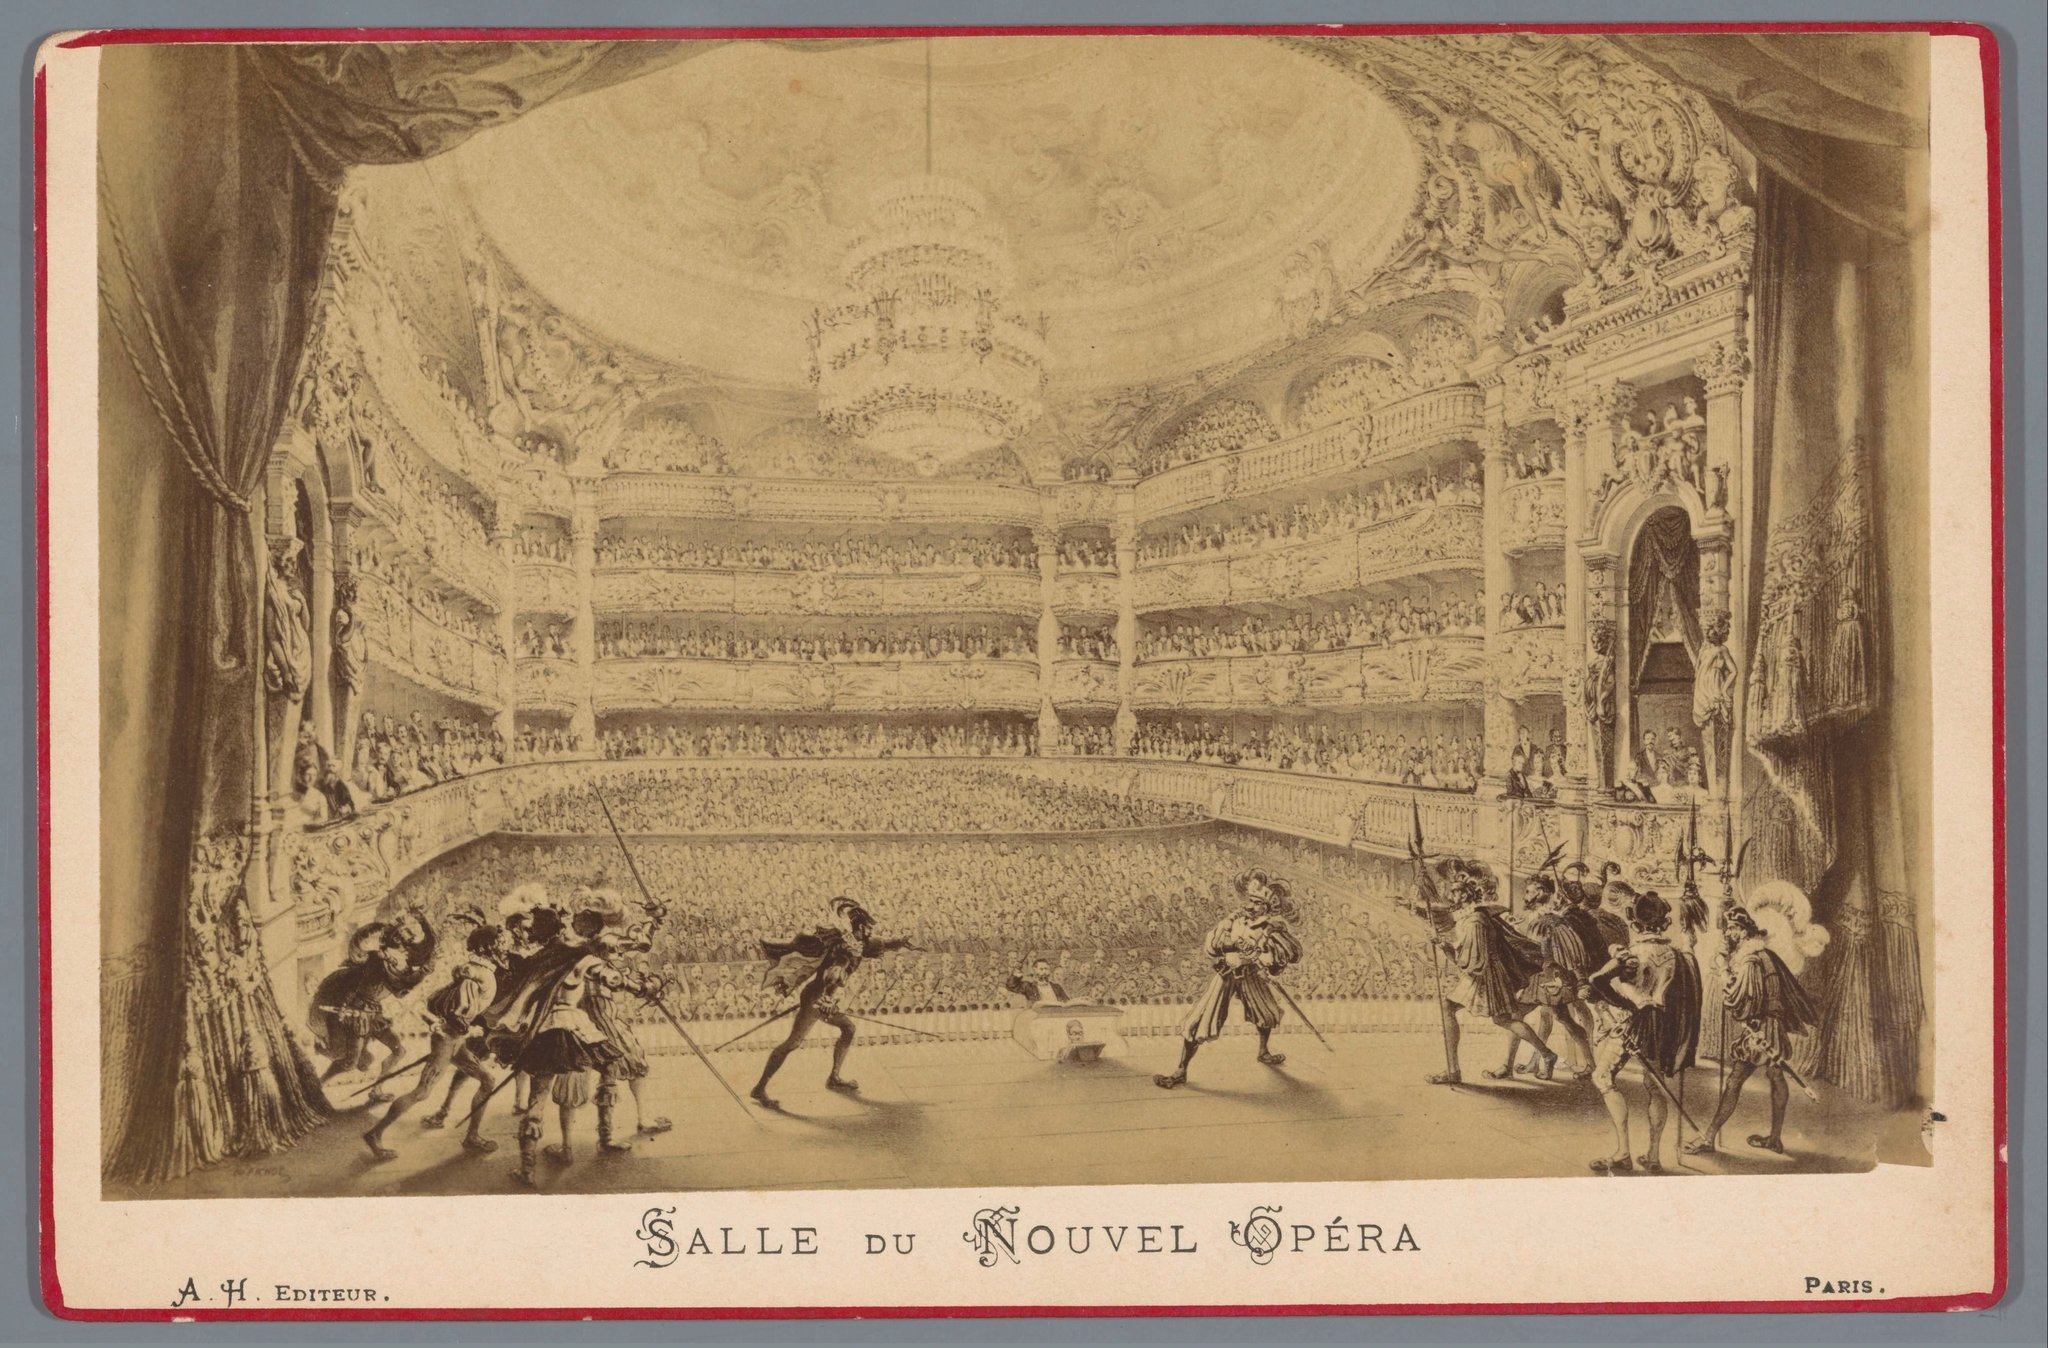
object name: photograph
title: Fotoreproductie van een tekening, voorstellende een opvoering op het podium in de Opéra Garnier te Parijs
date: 1875-1885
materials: cardboard, photographic support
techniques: albumen print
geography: france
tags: set, scenery ~ stage, opera house